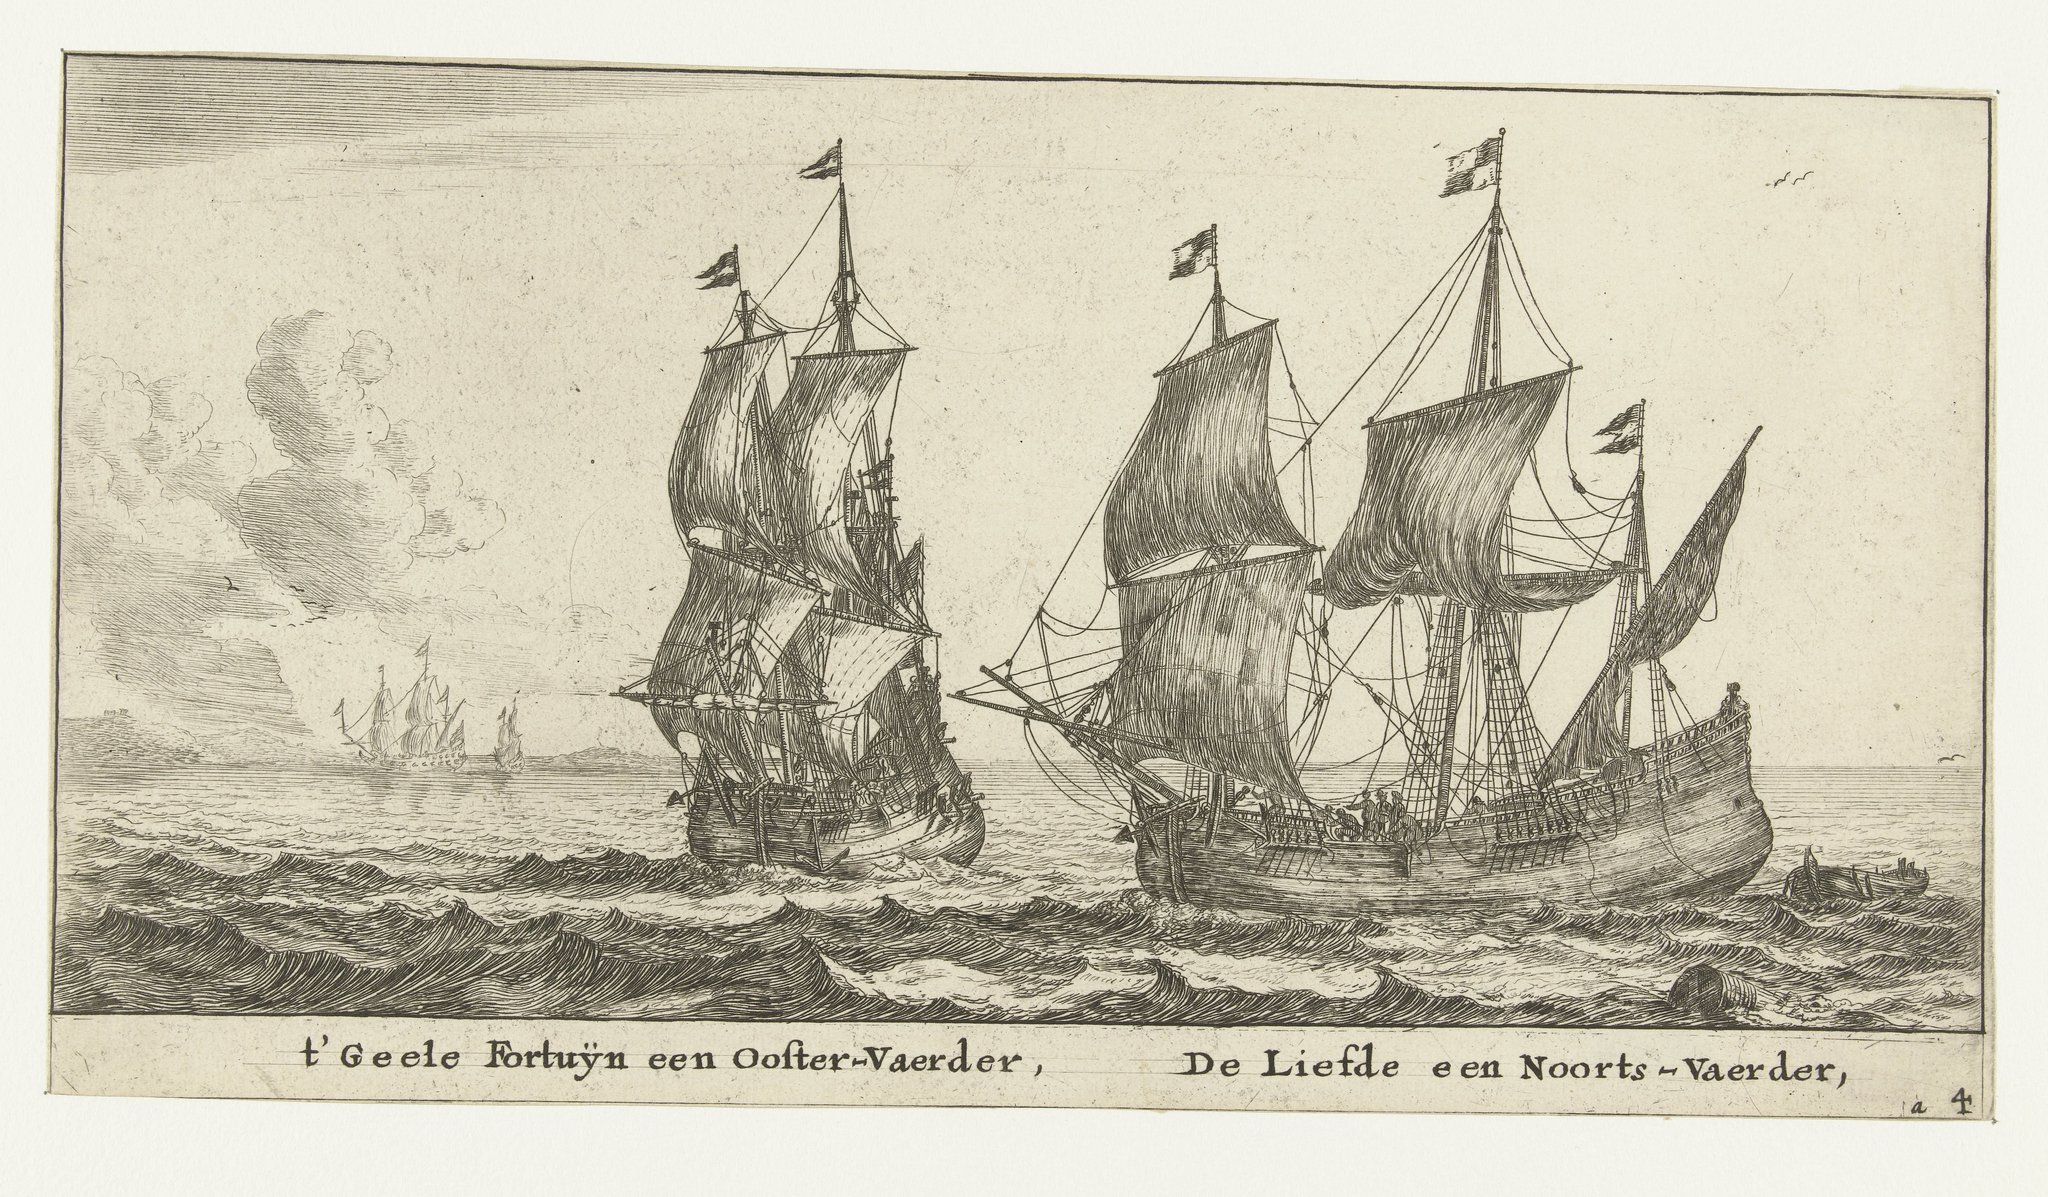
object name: print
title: Eerste deel. Verscheÿde schepen en gesichten van Amstelredam, naer t leven afgetekent en opt cooper gebracht, door Reinier Nooms, alÿas Zeeman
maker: reinier nooms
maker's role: draughtsman, painter, print maker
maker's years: 1623-1664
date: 1652-1654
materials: paper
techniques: drypoint, etching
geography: netherlands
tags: sailing-ship, sailing-boat (with name)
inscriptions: collector's mark: Lugt 12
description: 't Gele Fortuin, een koopvaardijschip varend op de Baltische landen, en De Liefde, een koopvaardijschip varend op Noorwegen.